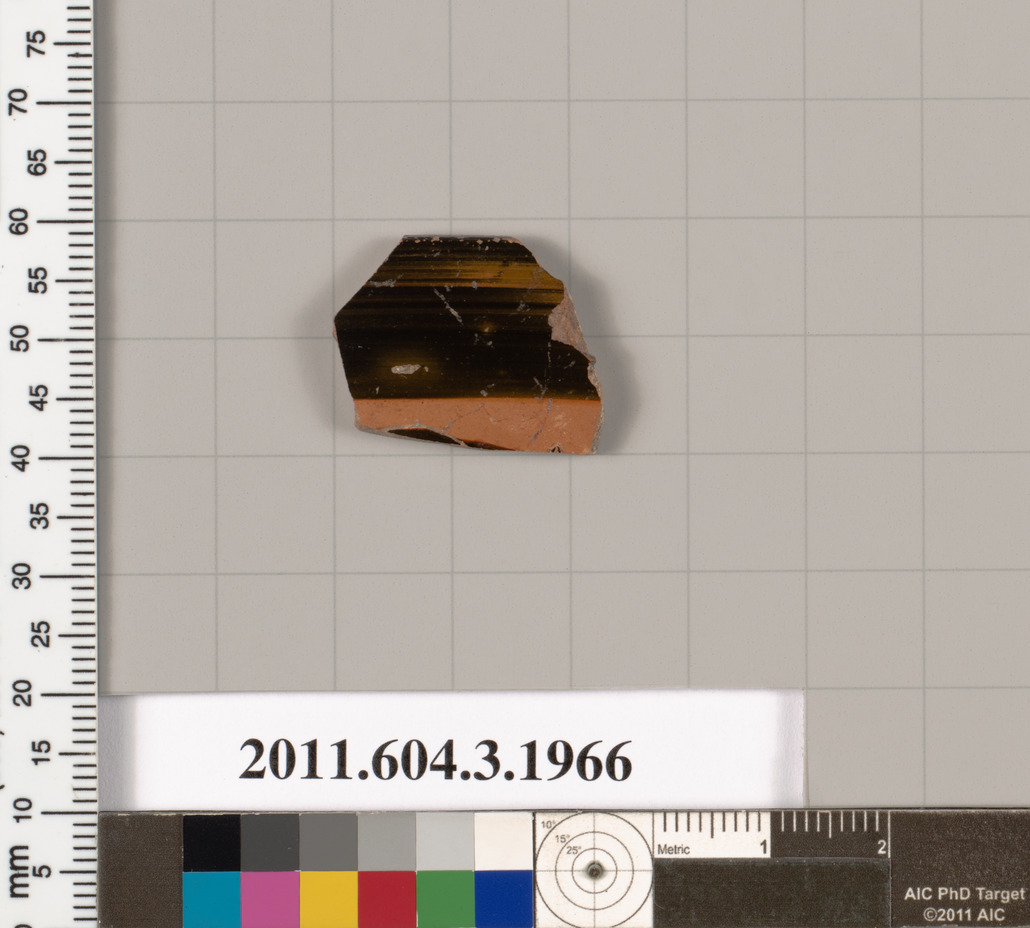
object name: kylix fragment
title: Terracotta fragment of a kylix (drinking cup)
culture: greek, attic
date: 550-526 BCE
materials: terracotta